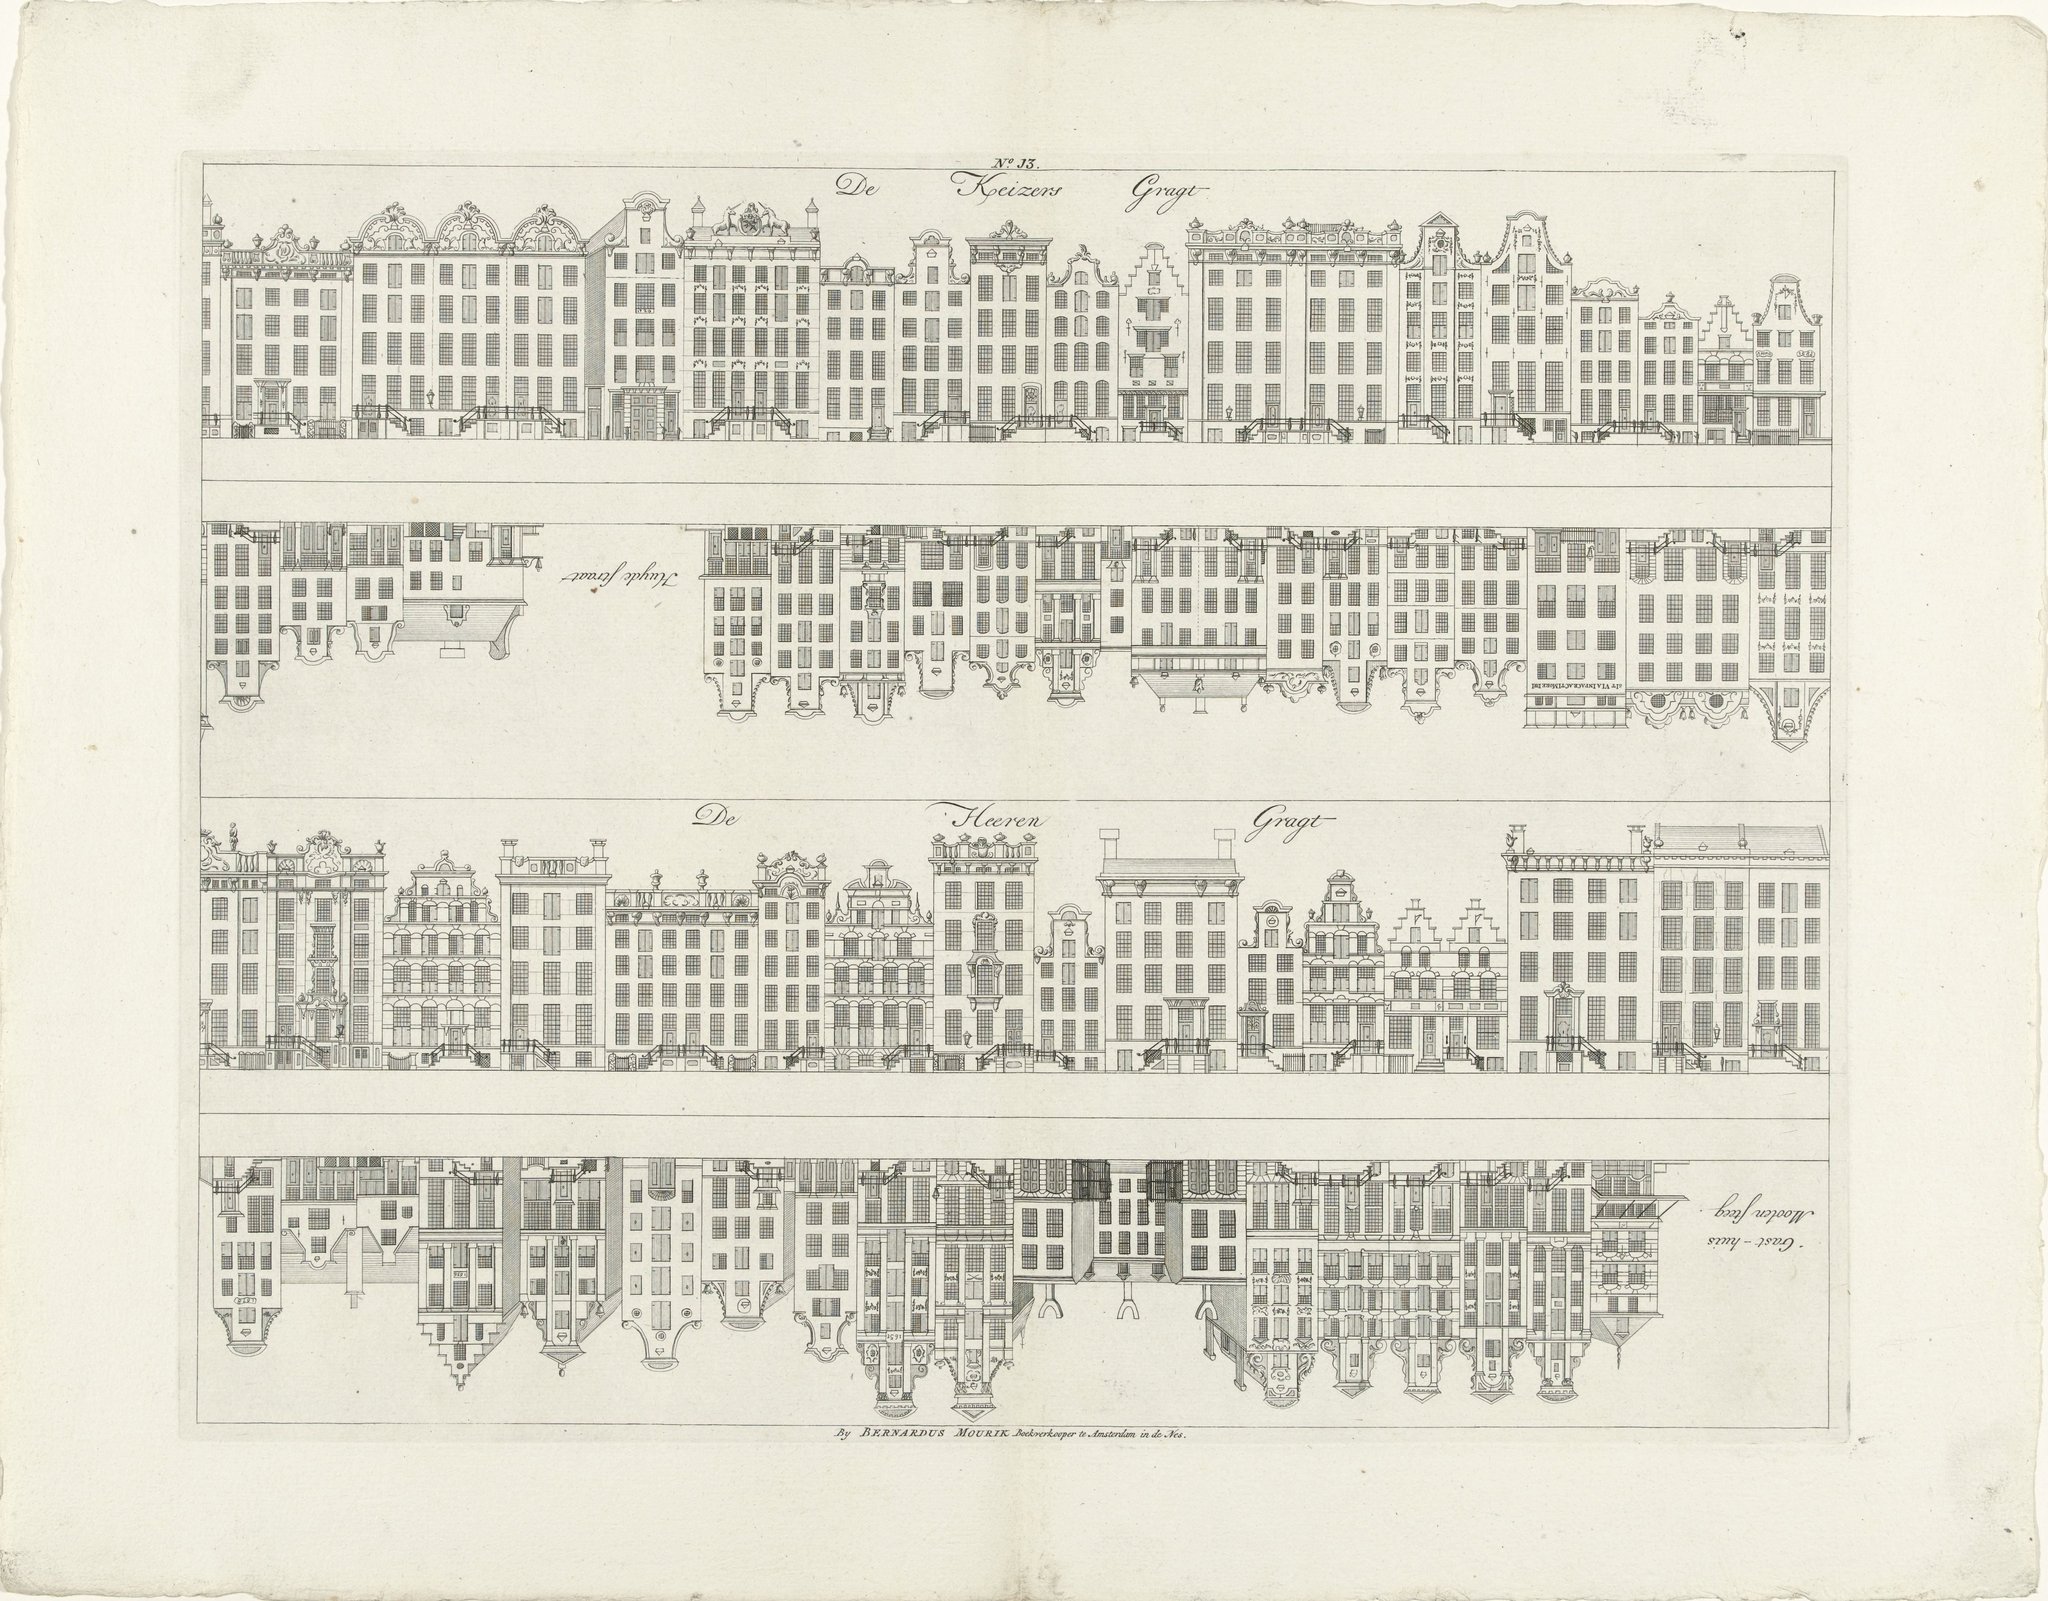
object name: print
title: Gevels van huizenrijen aan de Keizersgracht naar de Huidenstraat en de Herengracht naar de Gasthuismolensteeg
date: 1768-1771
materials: paper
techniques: etching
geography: amsterdam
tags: front façade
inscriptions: collector's mark: Lugt 2228, collector's mark: Lugt 2233